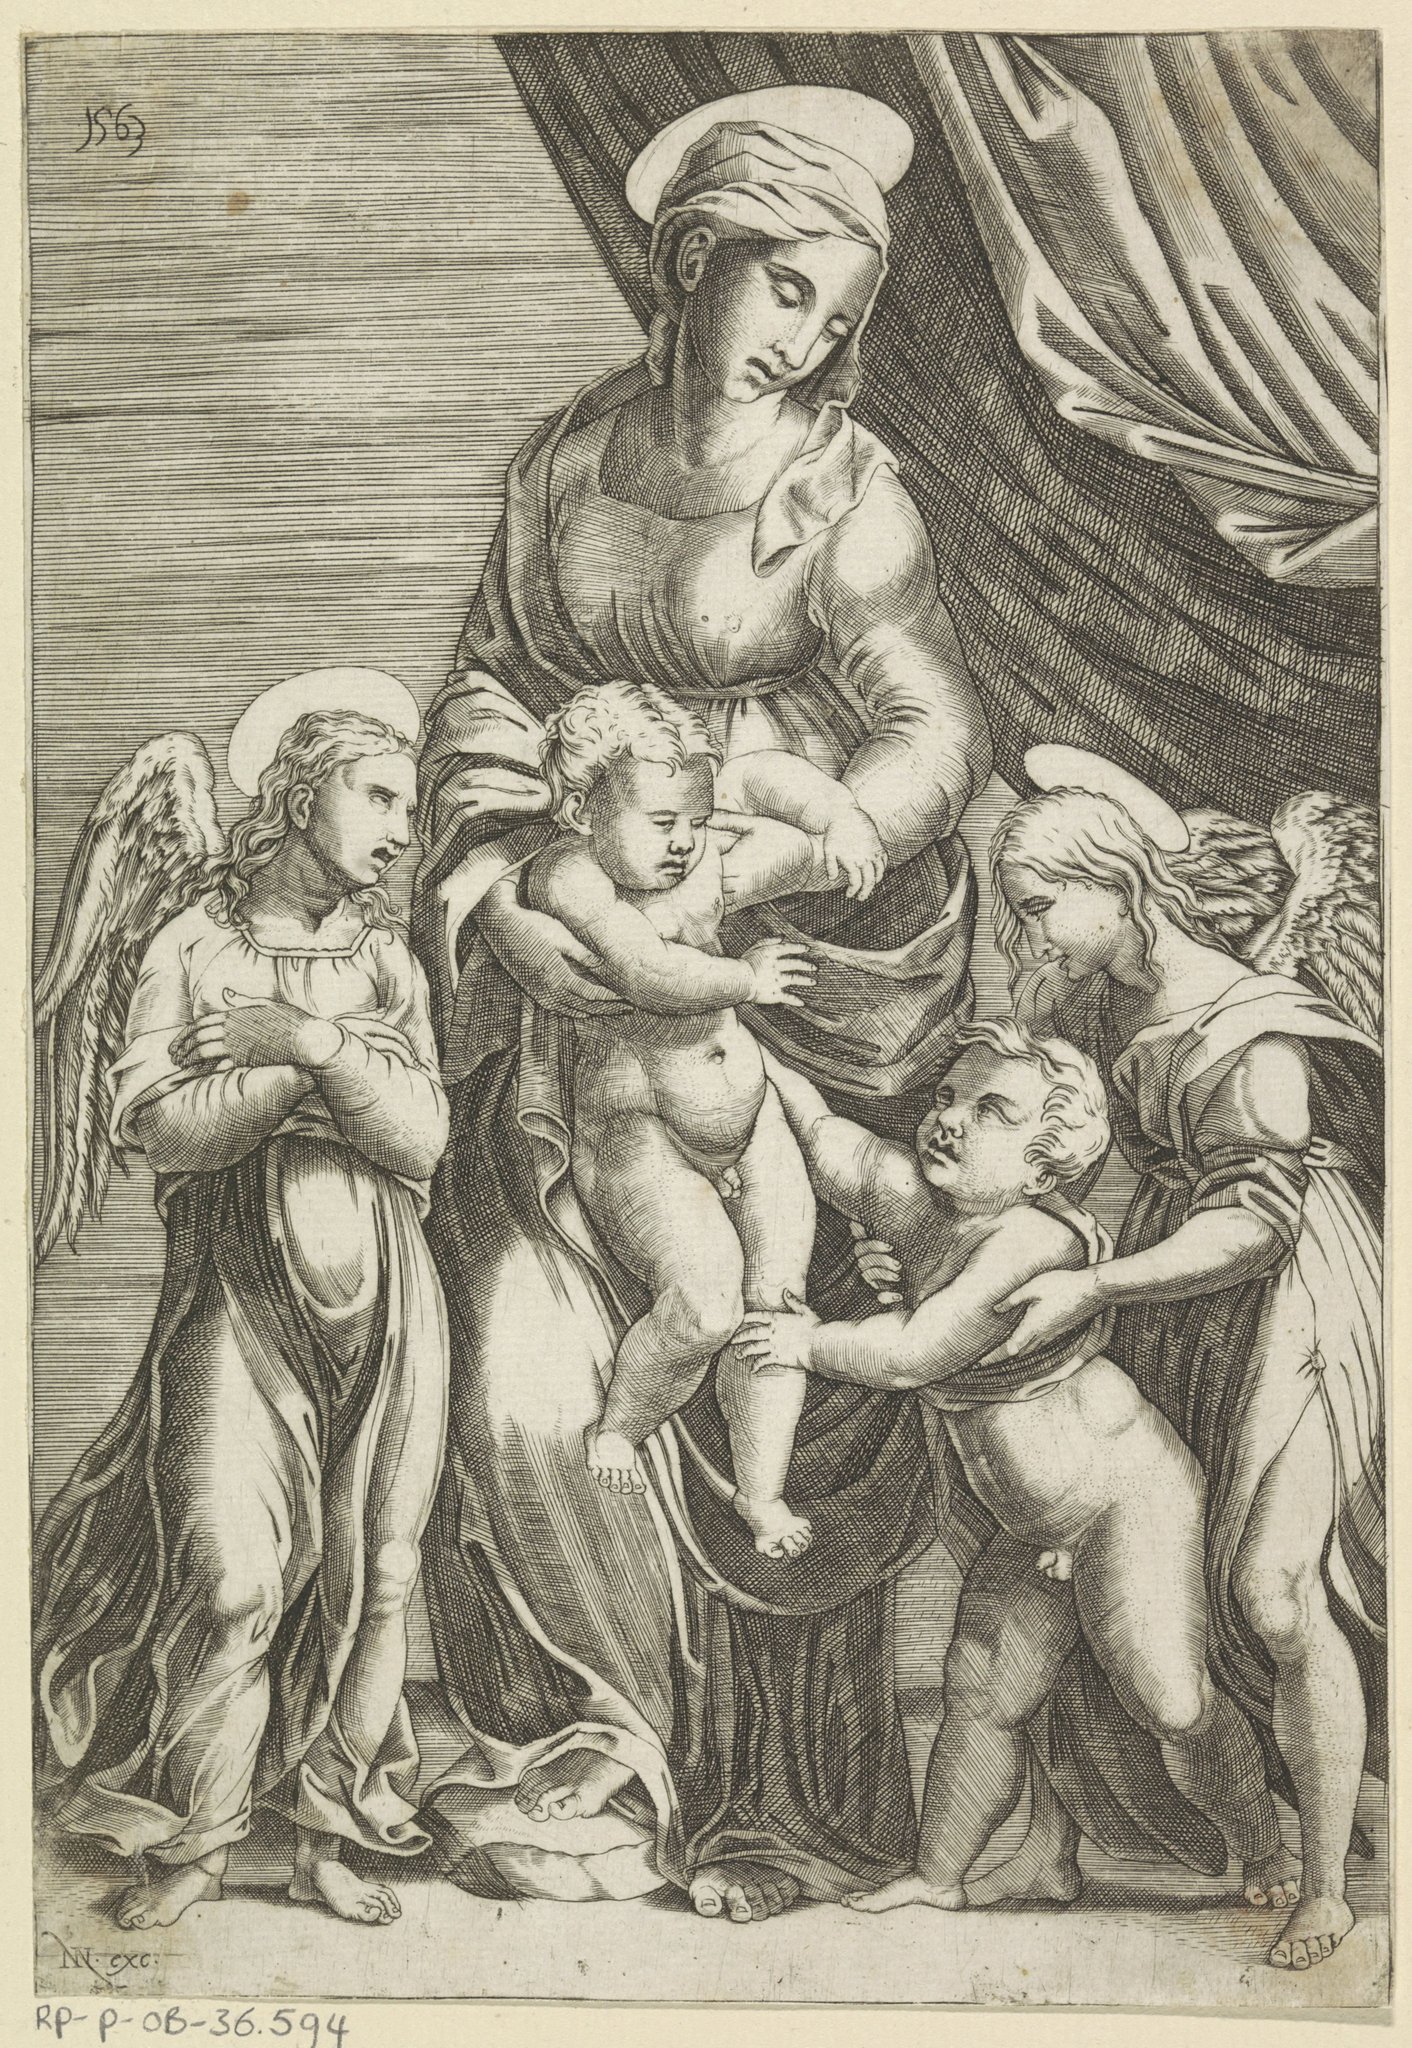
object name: print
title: Maria met Kind en de jonge Johannes de Doper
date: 1563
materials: paper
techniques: engraving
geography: italy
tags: mary and the christ-child with john the baptist (as child) (+ angel(s))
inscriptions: collector's mark: Lugt 12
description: Maria staat met het Christuskind in haar handen. De jonge Johannes de Doper staat naast haar en strekt zijn armen uit naar Christus. Zij worden geflankeerd door twee engelen. Rechts een gordijn.